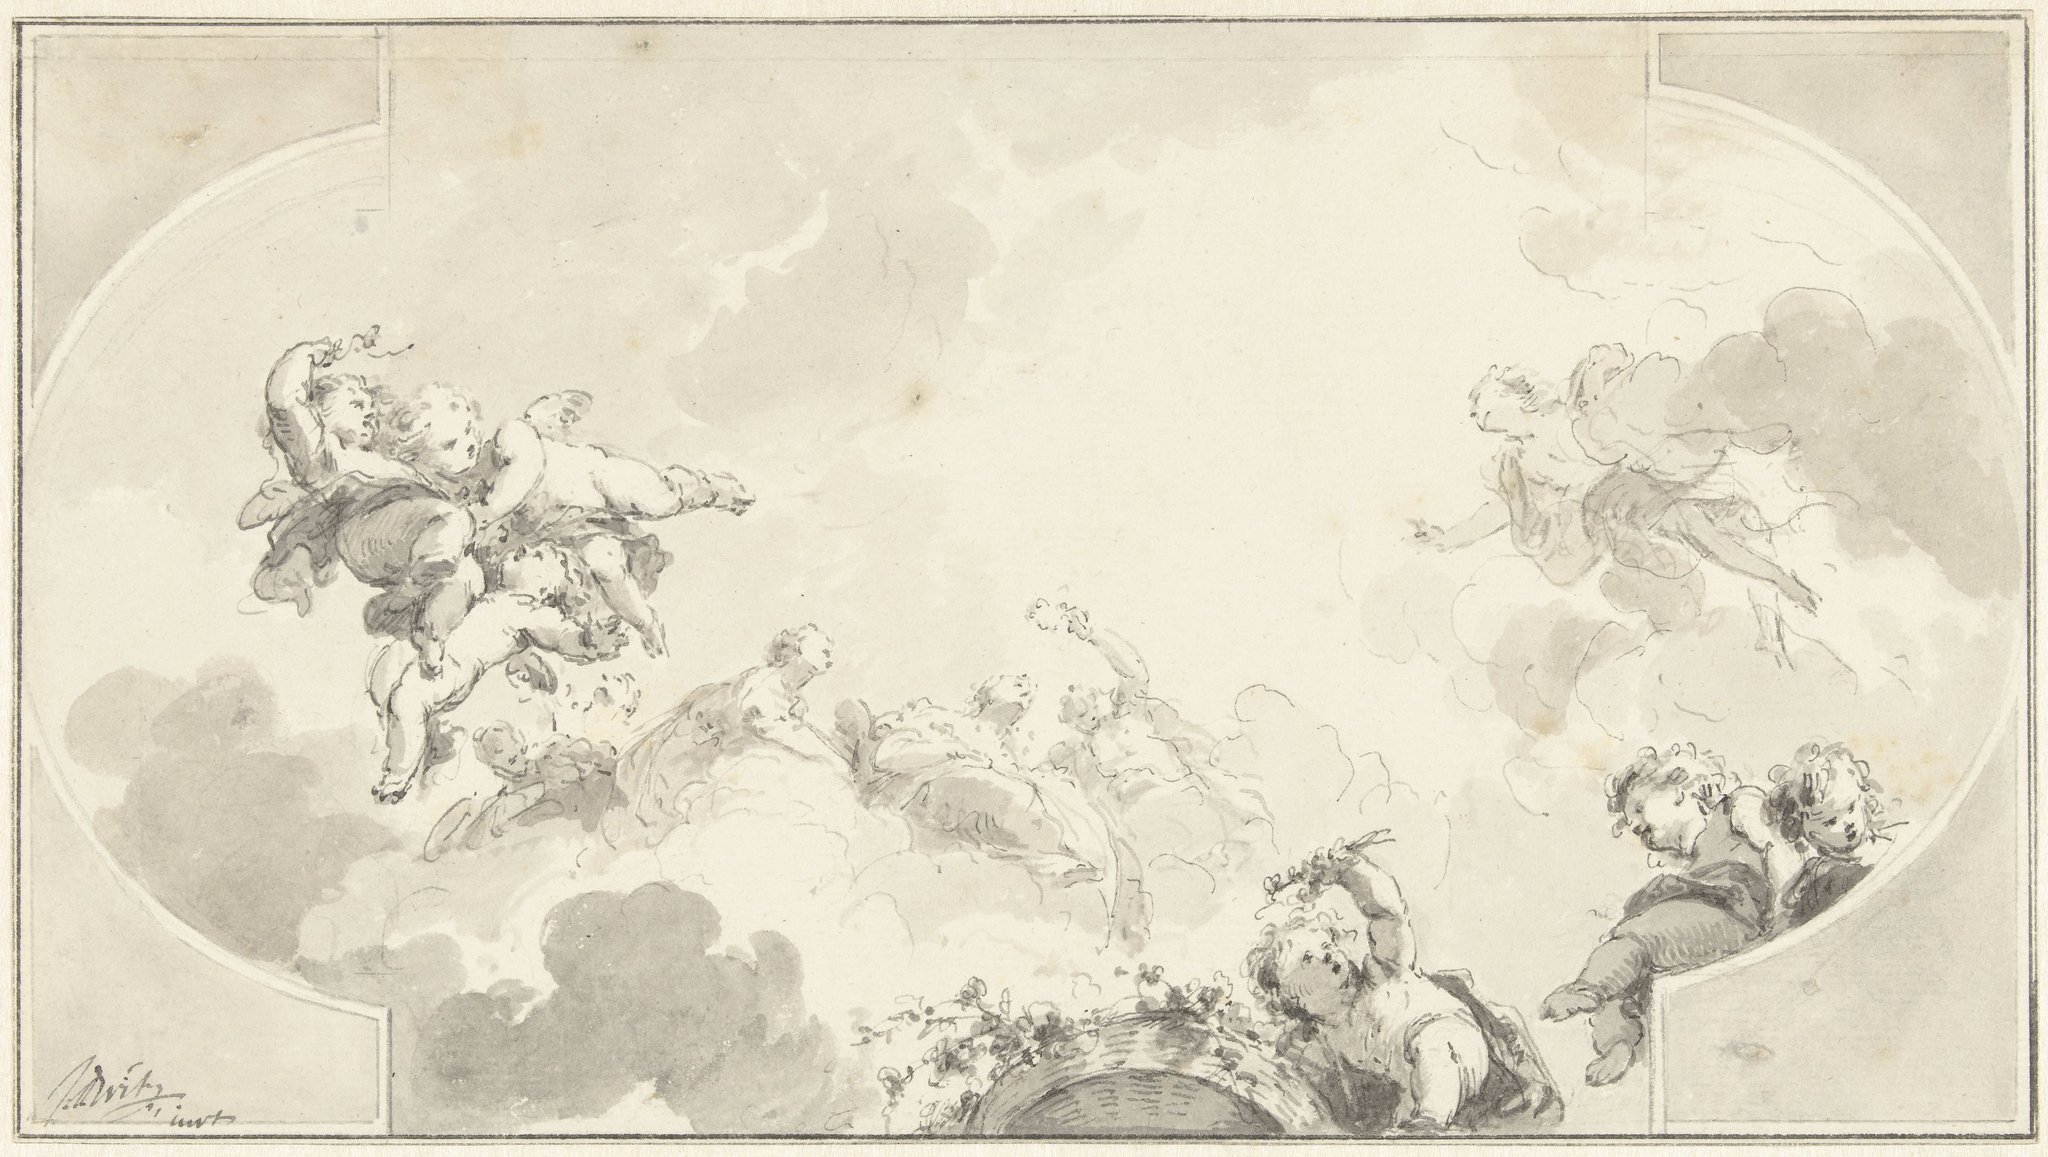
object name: design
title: Ontwerp voor plafondschildering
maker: jacob de wit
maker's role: draughtsman, painter, print maker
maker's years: 1695-1754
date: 1705-1754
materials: ink, paper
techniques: brush, pen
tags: cupids: 'amores', 'amoretti', 'putti'